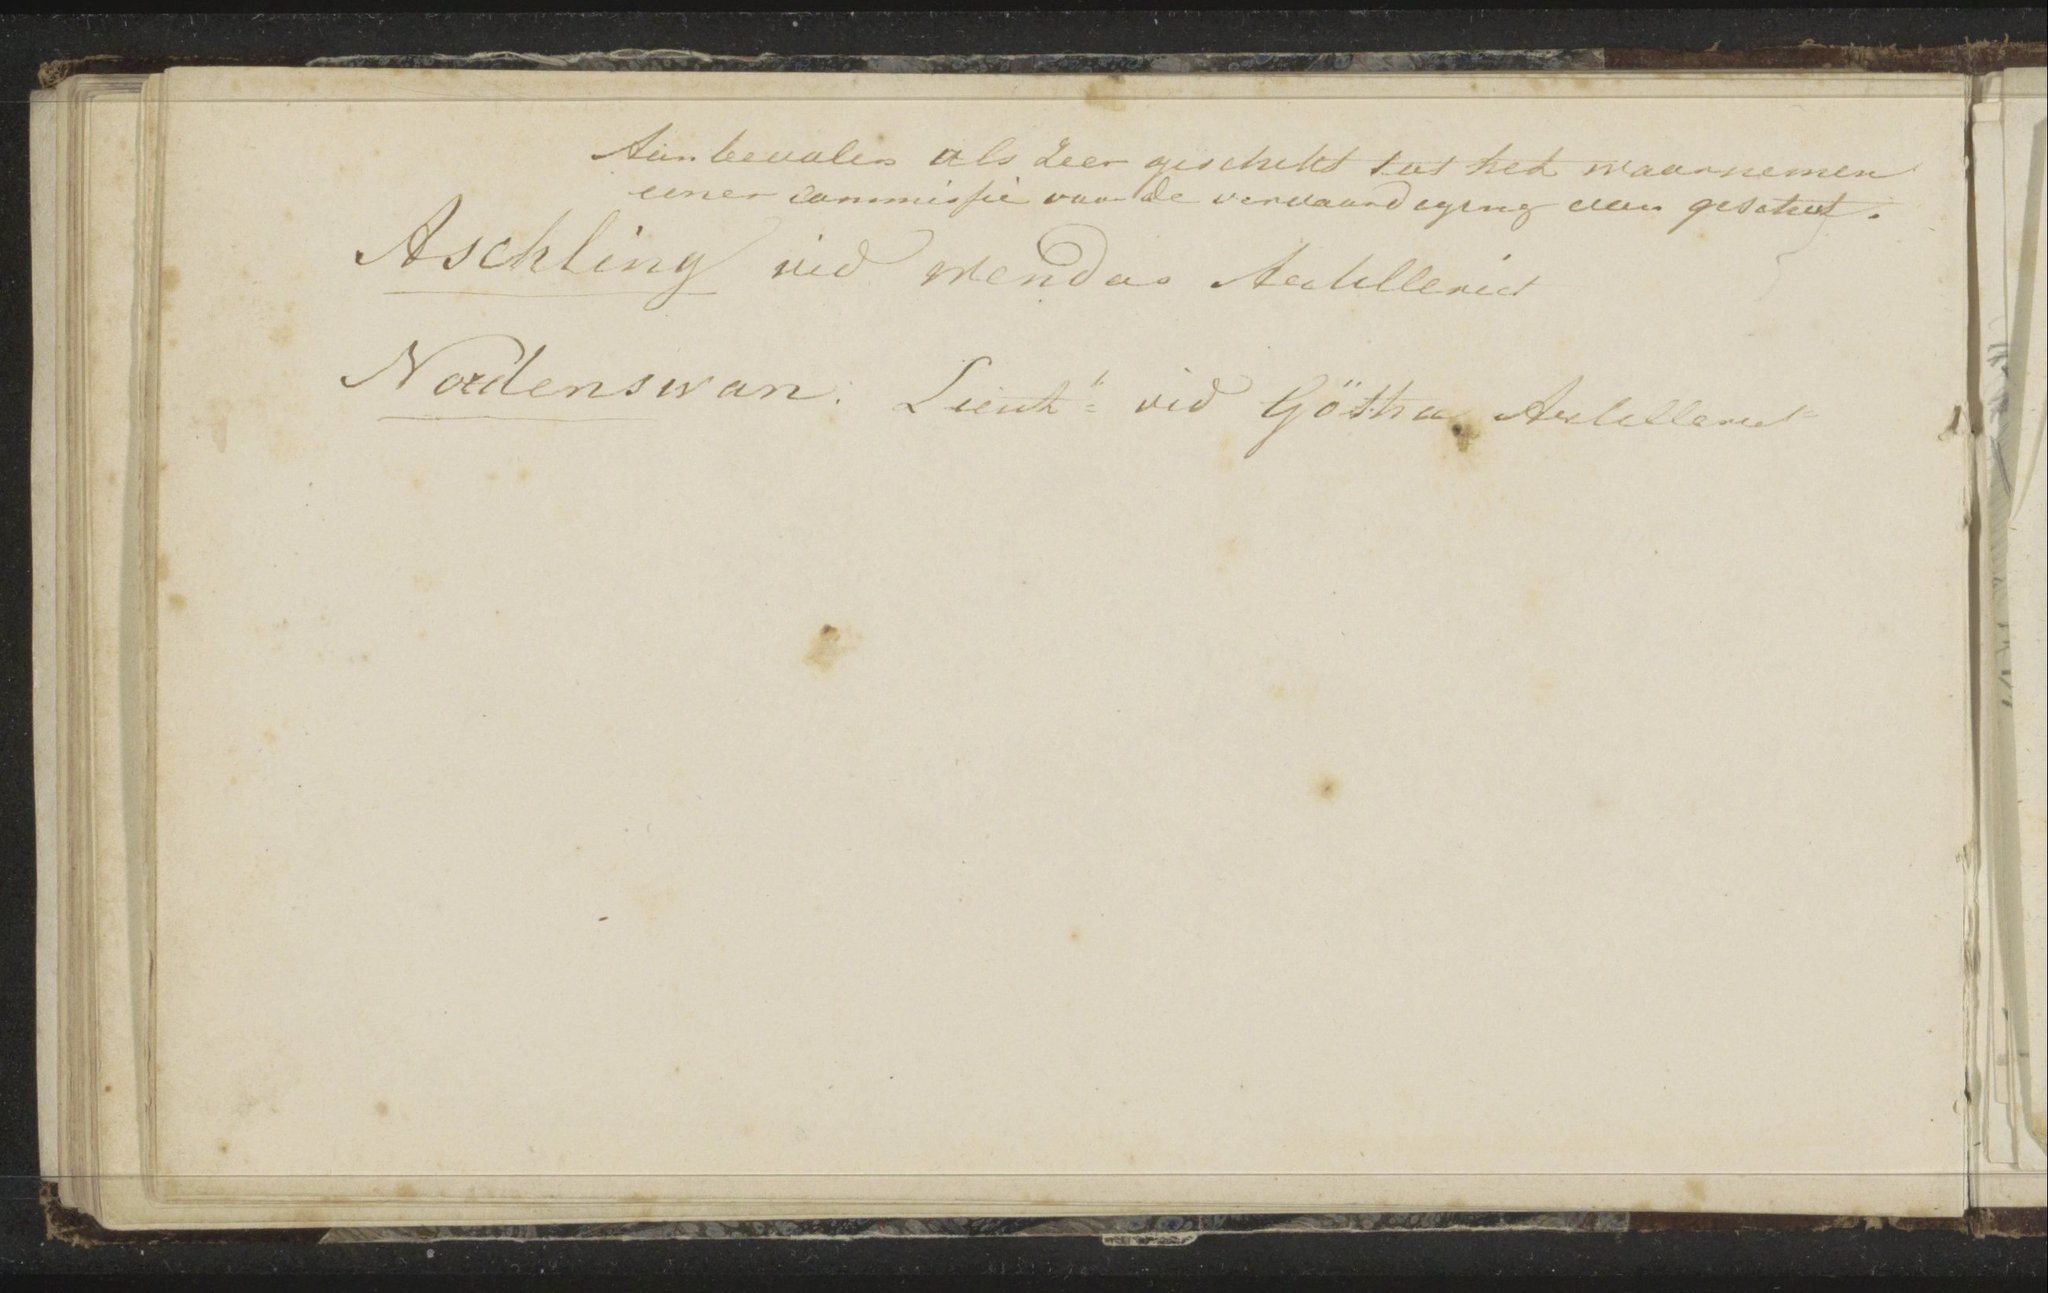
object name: sketchbook leaf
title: Namen van Zweedse militairen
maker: christian heinrich gottlieb steuerwald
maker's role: draughtsman, print maker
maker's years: 1802-1874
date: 1845-1848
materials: ink, paper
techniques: pen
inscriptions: annotation: ‘Aanbevolen als zeer geschikt ... Götha A[...]nd’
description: Blad 61 verso uit een schetsboek met 61 bladen.